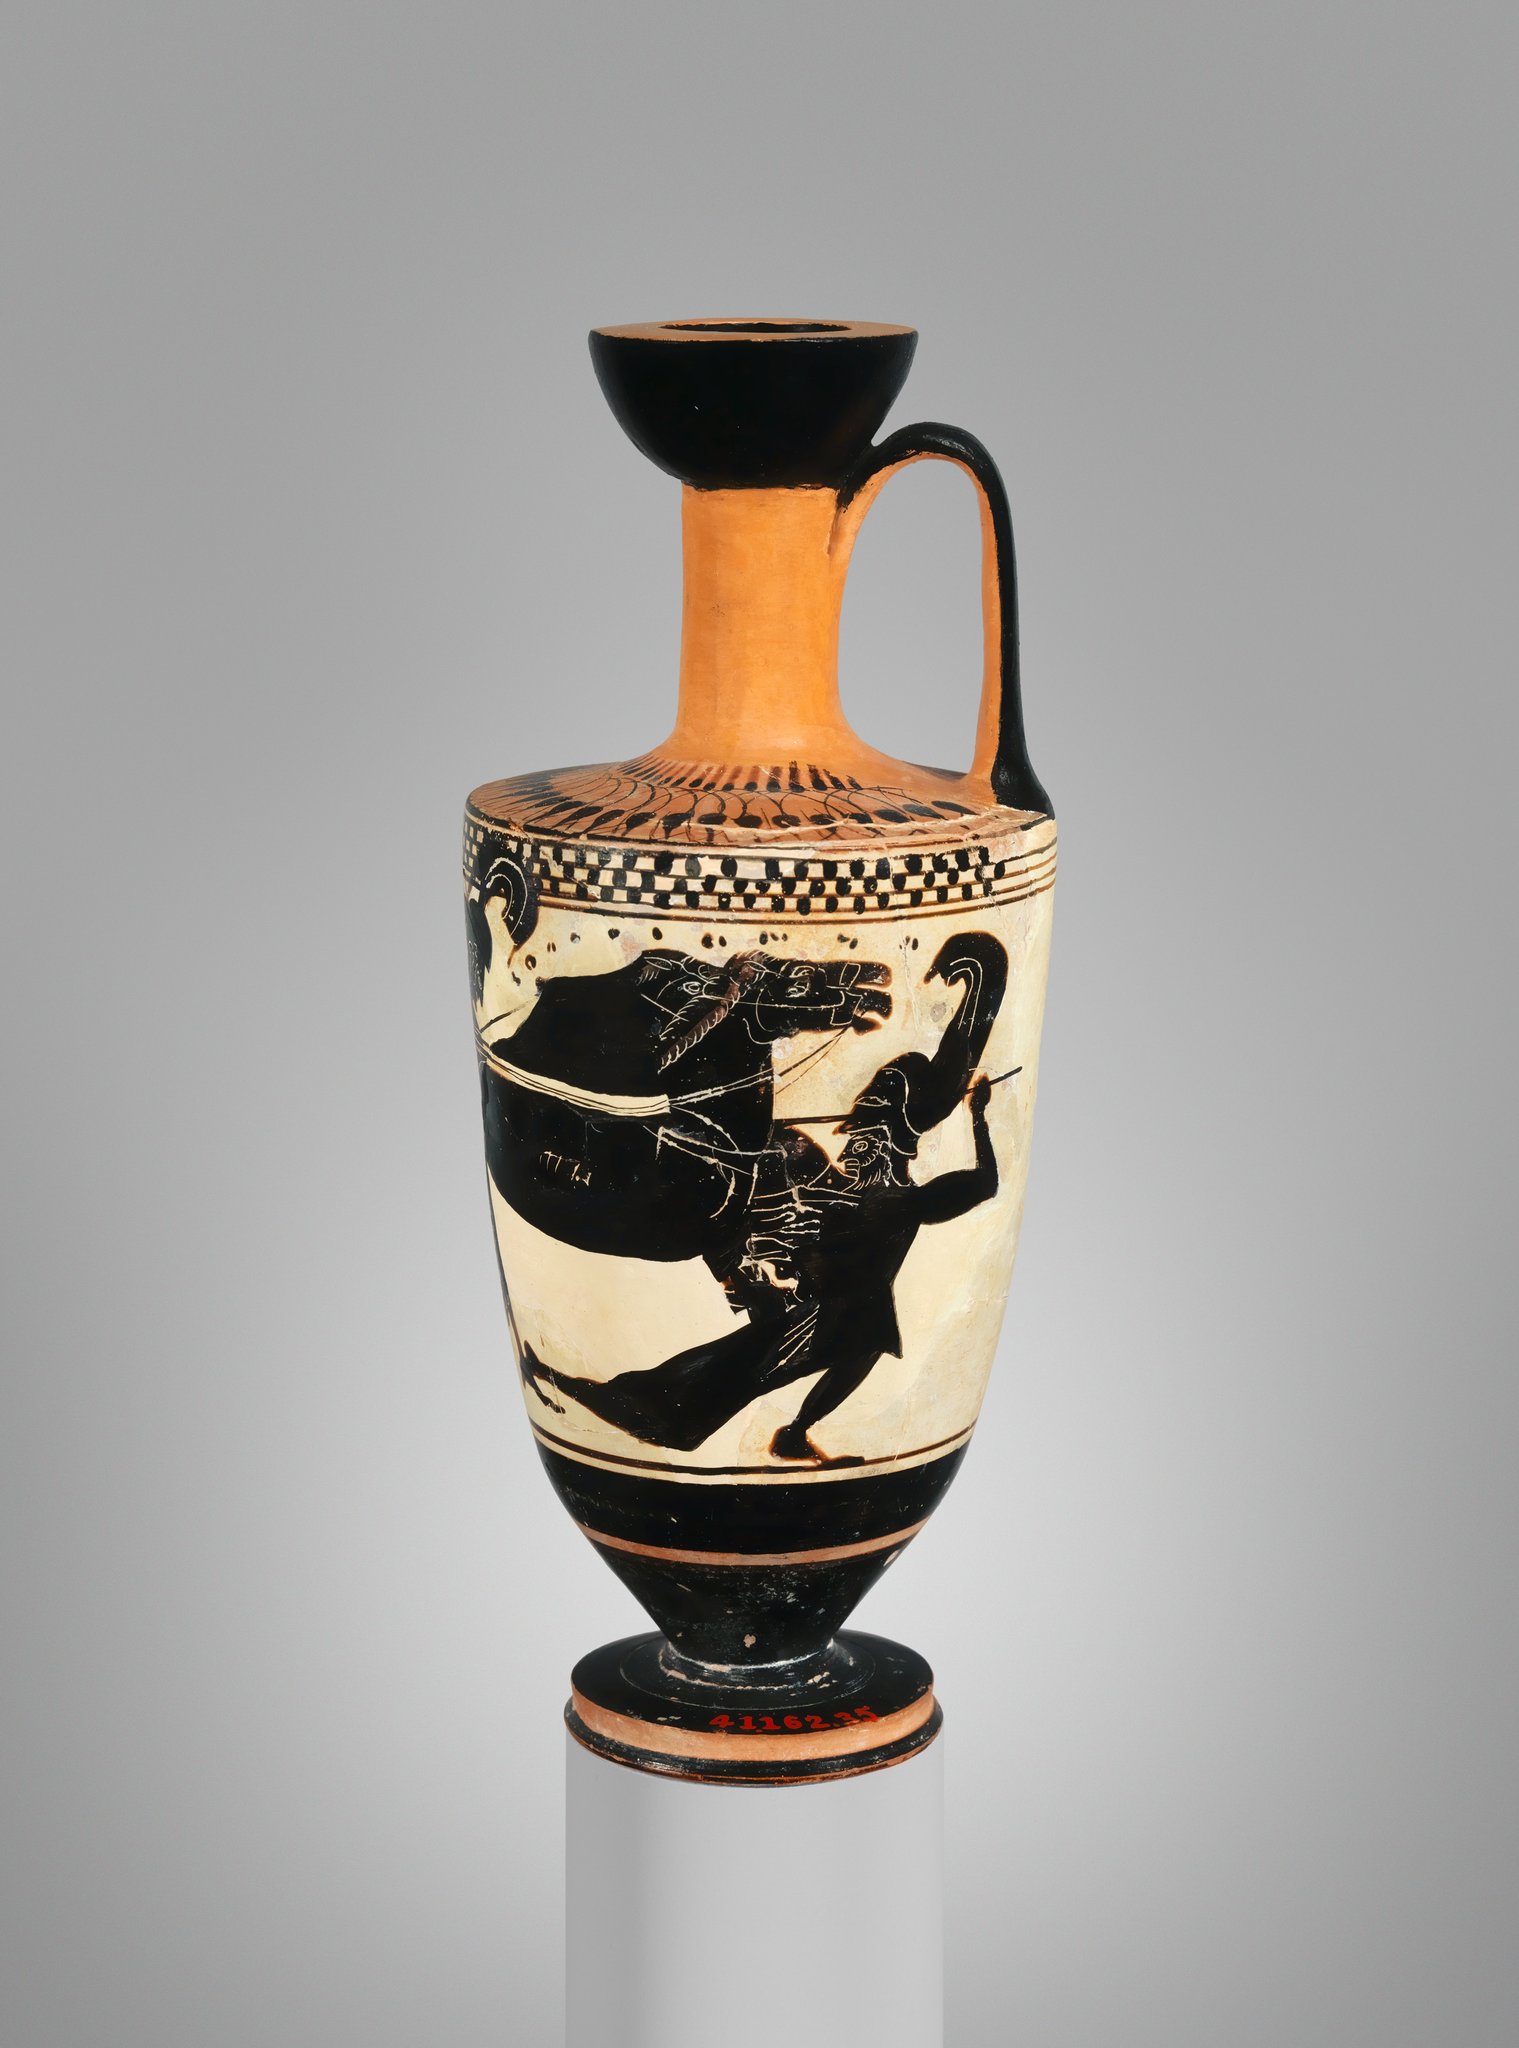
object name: lekythos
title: Terracotta lekythos (oil flask)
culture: greek, attic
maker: sappho painter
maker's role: artist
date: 500 BCE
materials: terracotta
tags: athena,horses,chariots